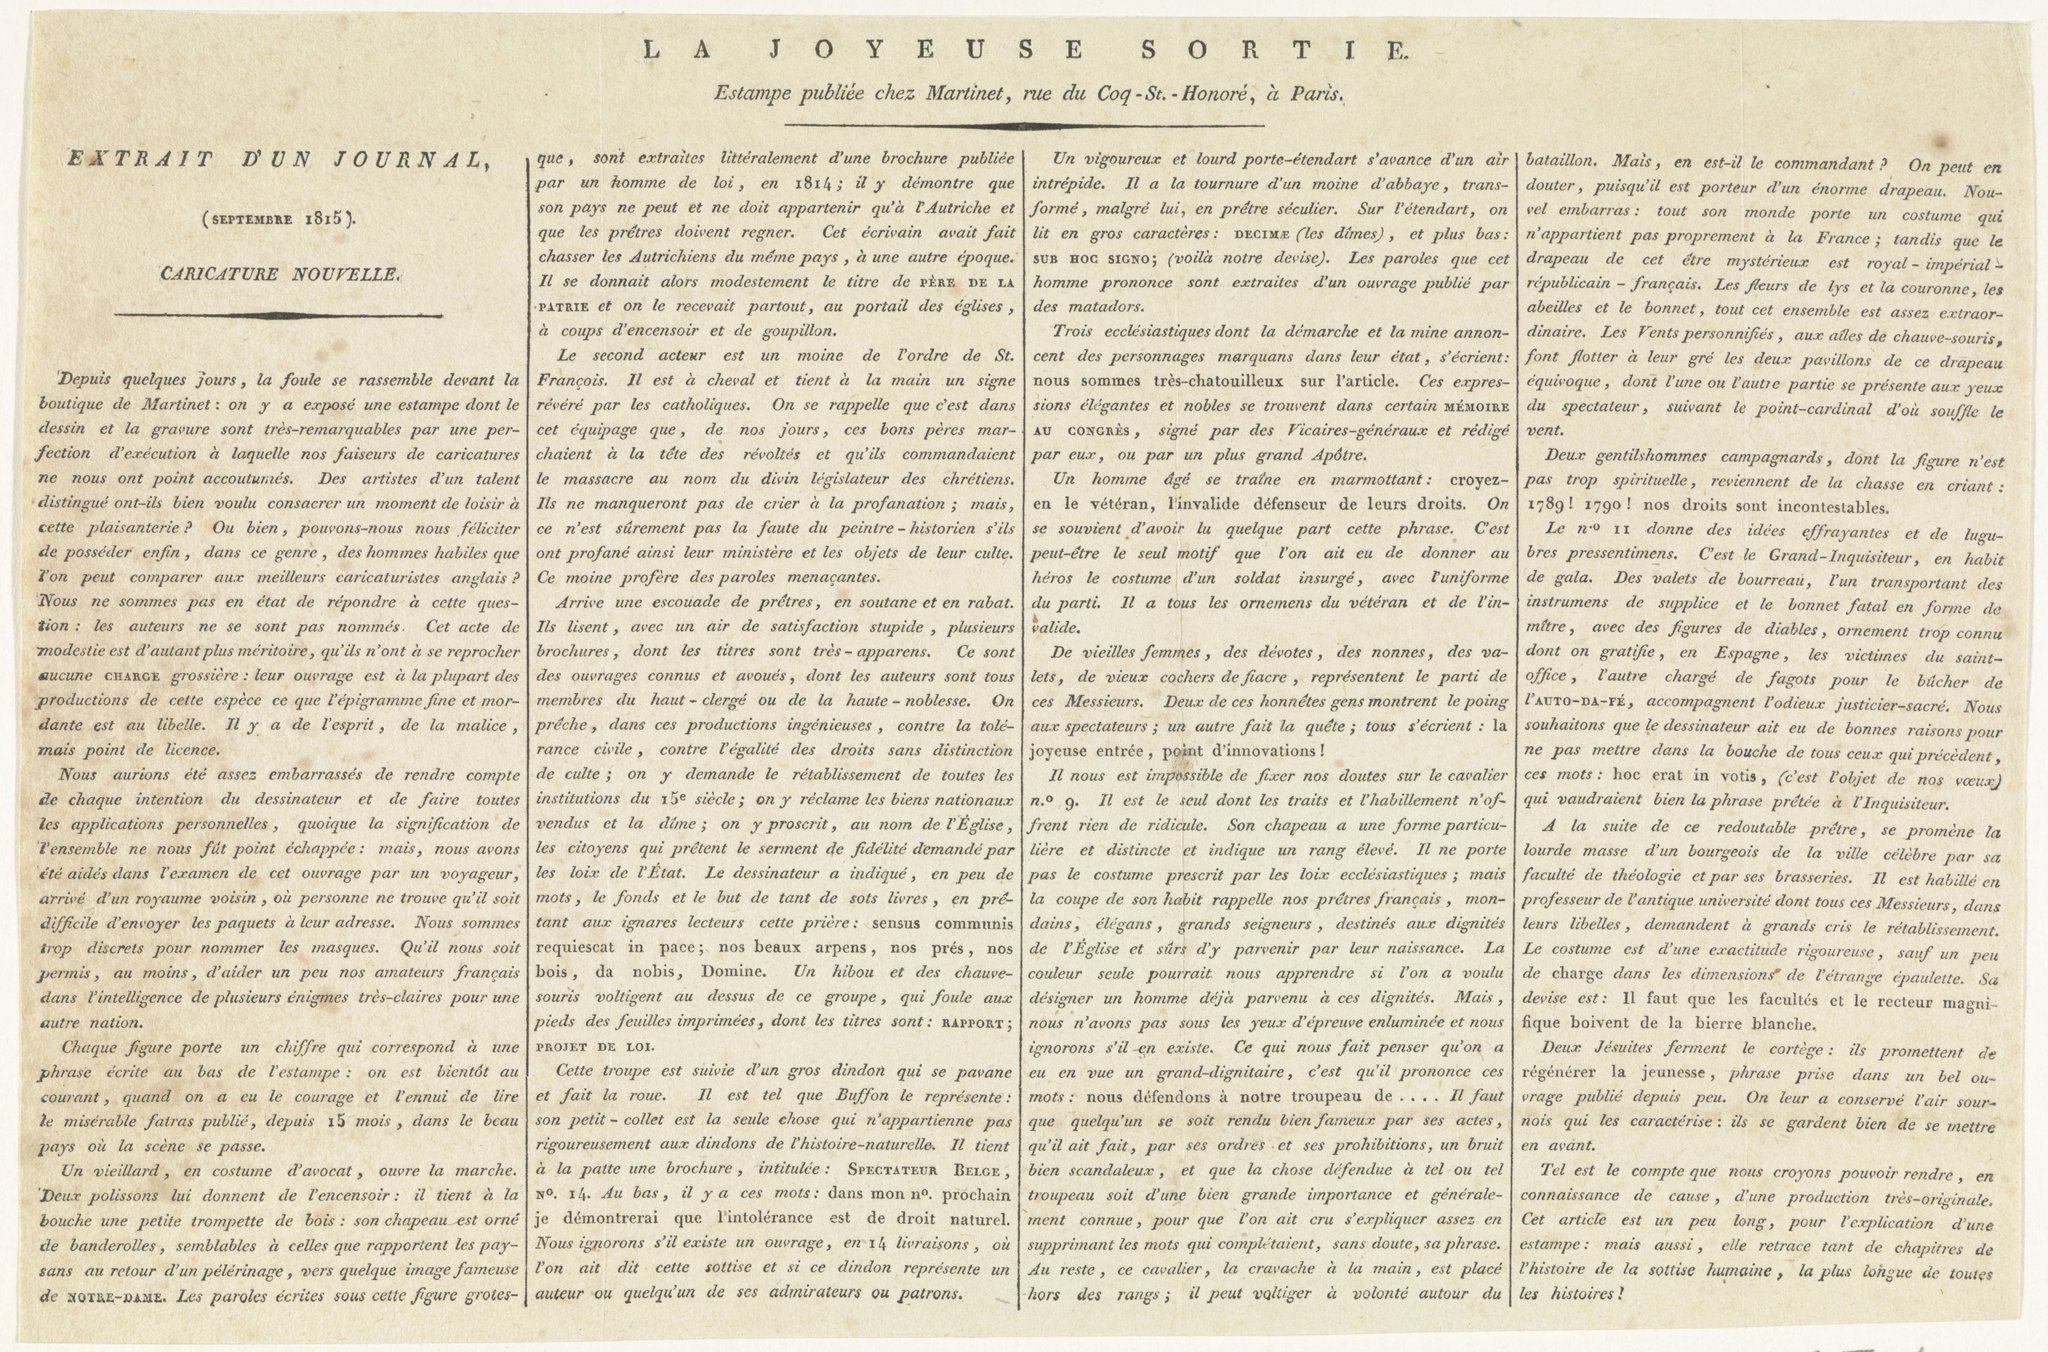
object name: text sheet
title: De blijde uittocht, 1815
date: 1809-1815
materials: paper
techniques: letterpress printing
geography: paris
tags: bevrijding van nederland (1815)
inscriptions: collector's mark: Lugt 2228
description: Tekstblad behorend bij de spotprent op het vertrek van de Fransen uit Nederland, 1815. Tekst in vier kolommen in het Frans.